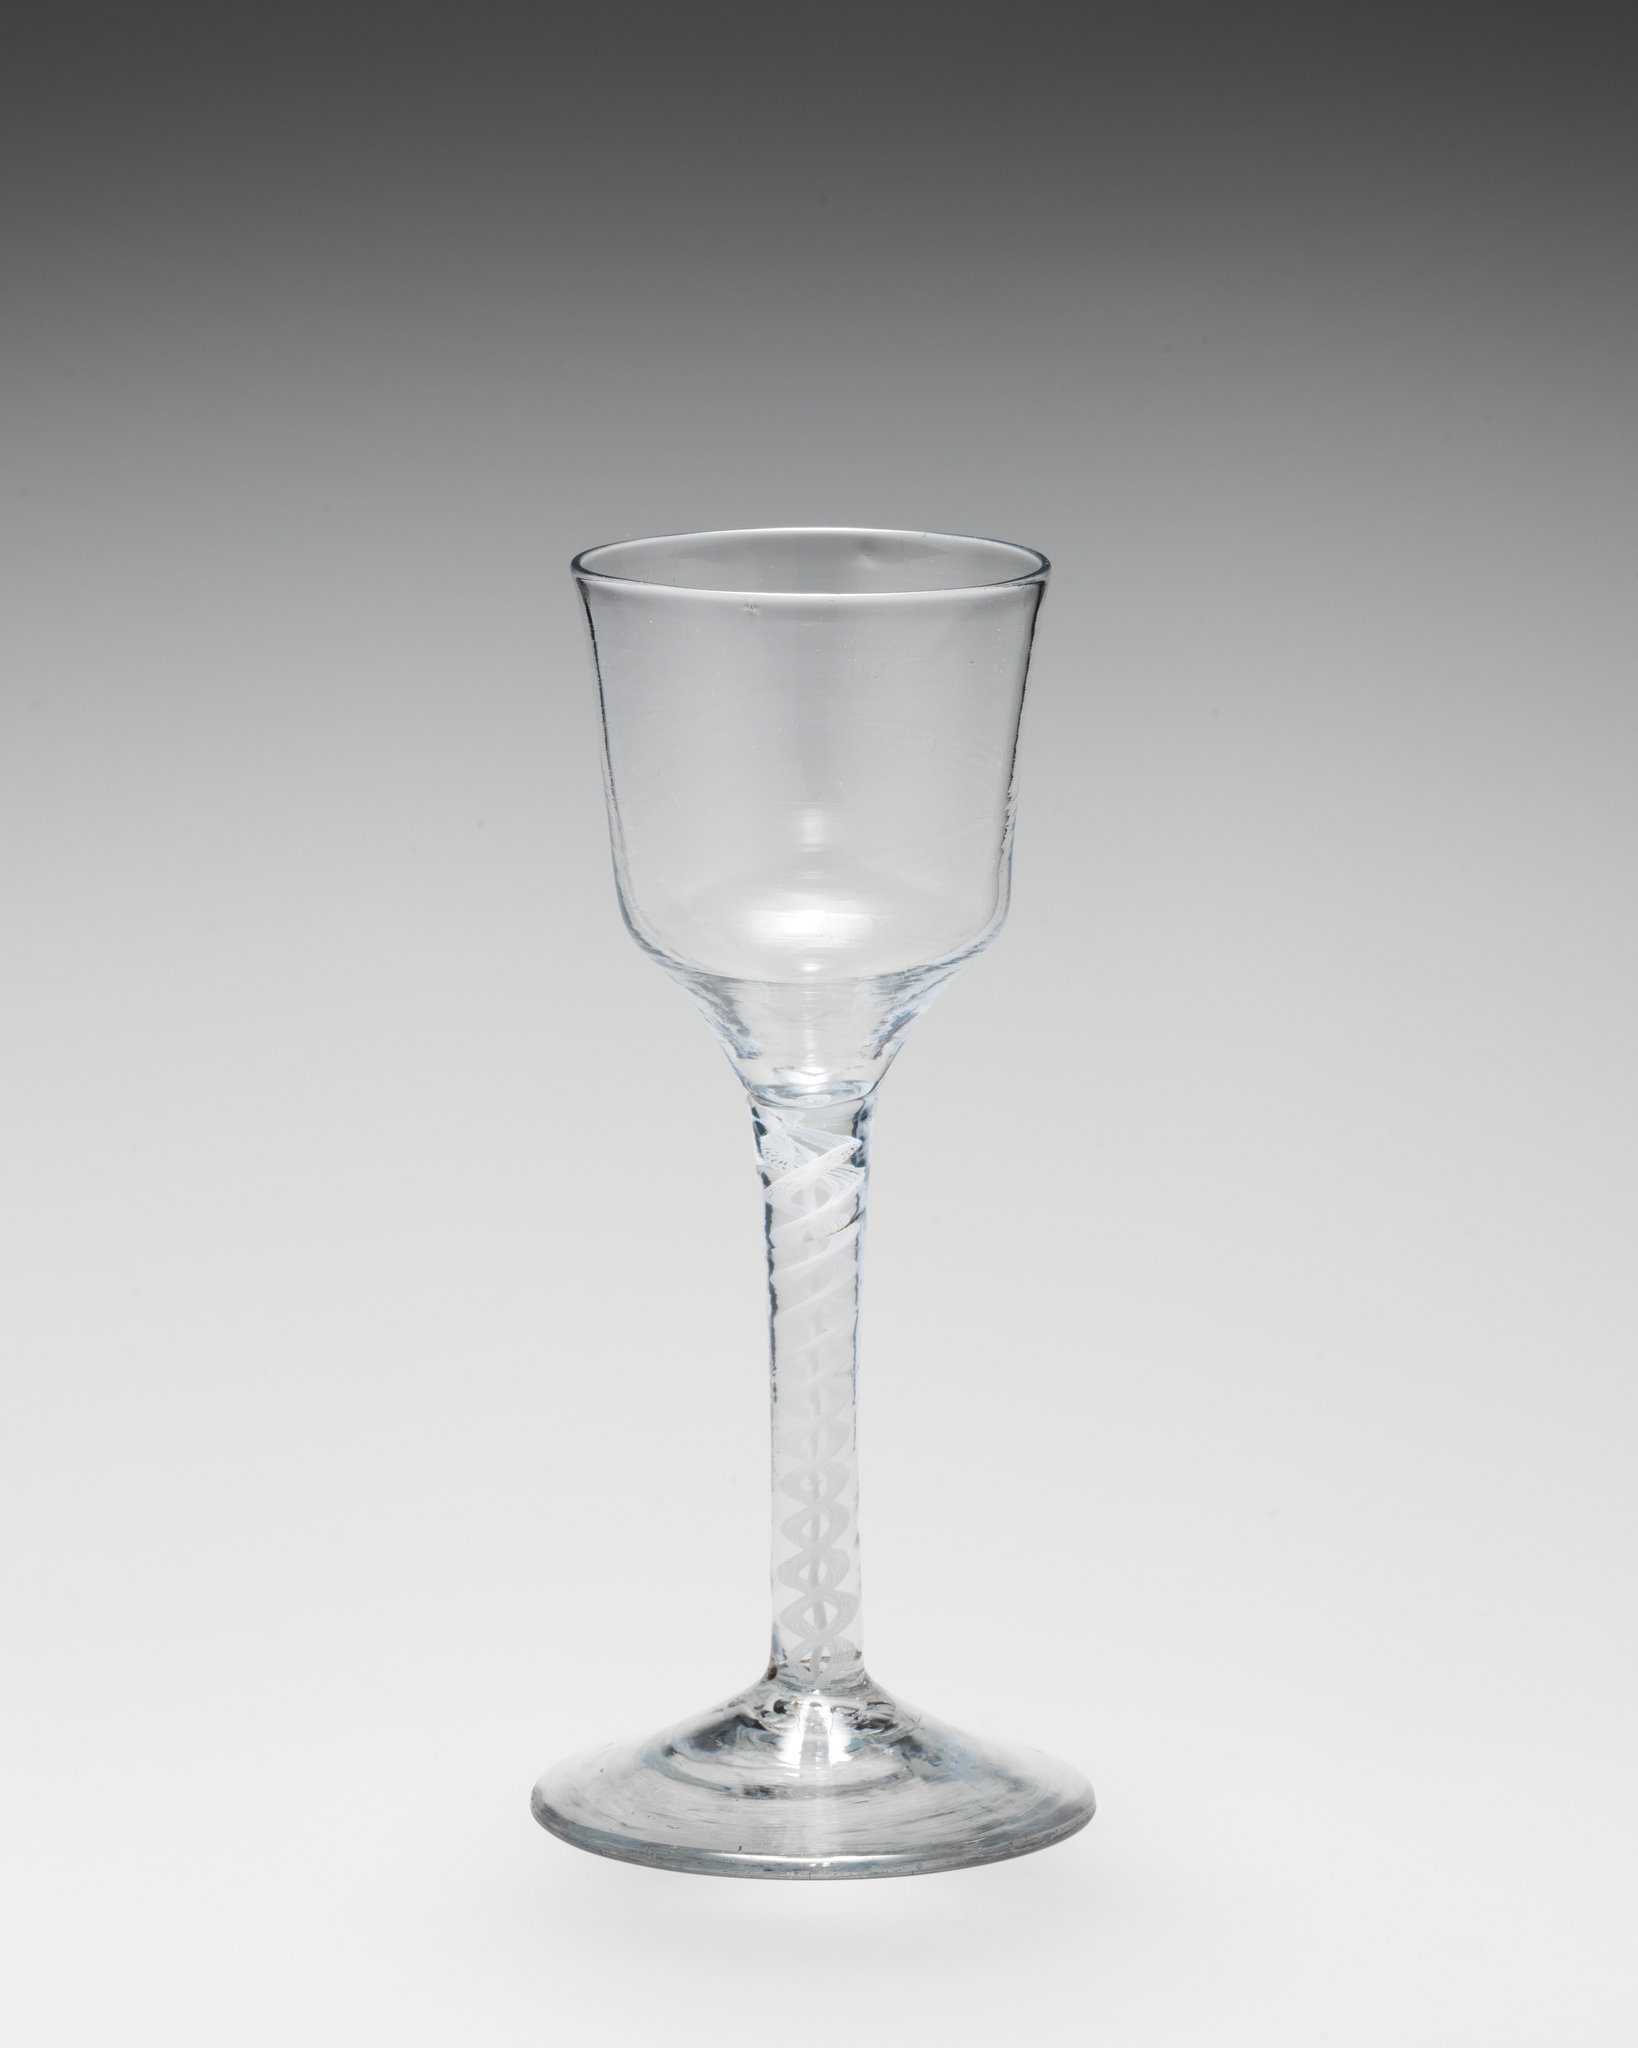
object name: wineglass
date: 1750-1800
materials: glass